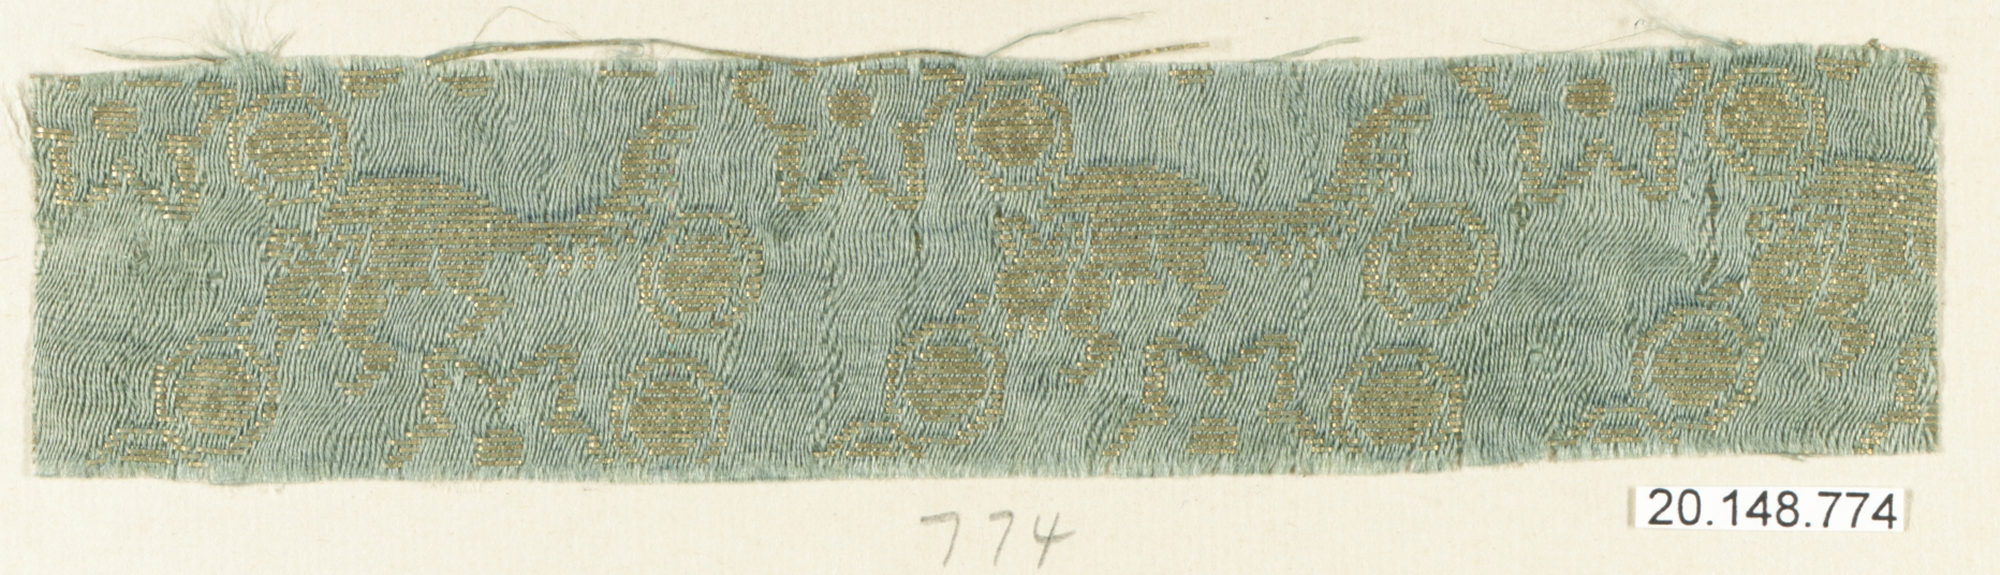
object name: piece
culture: japanese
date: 1601-1700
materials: silk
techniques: compound weave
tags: animals